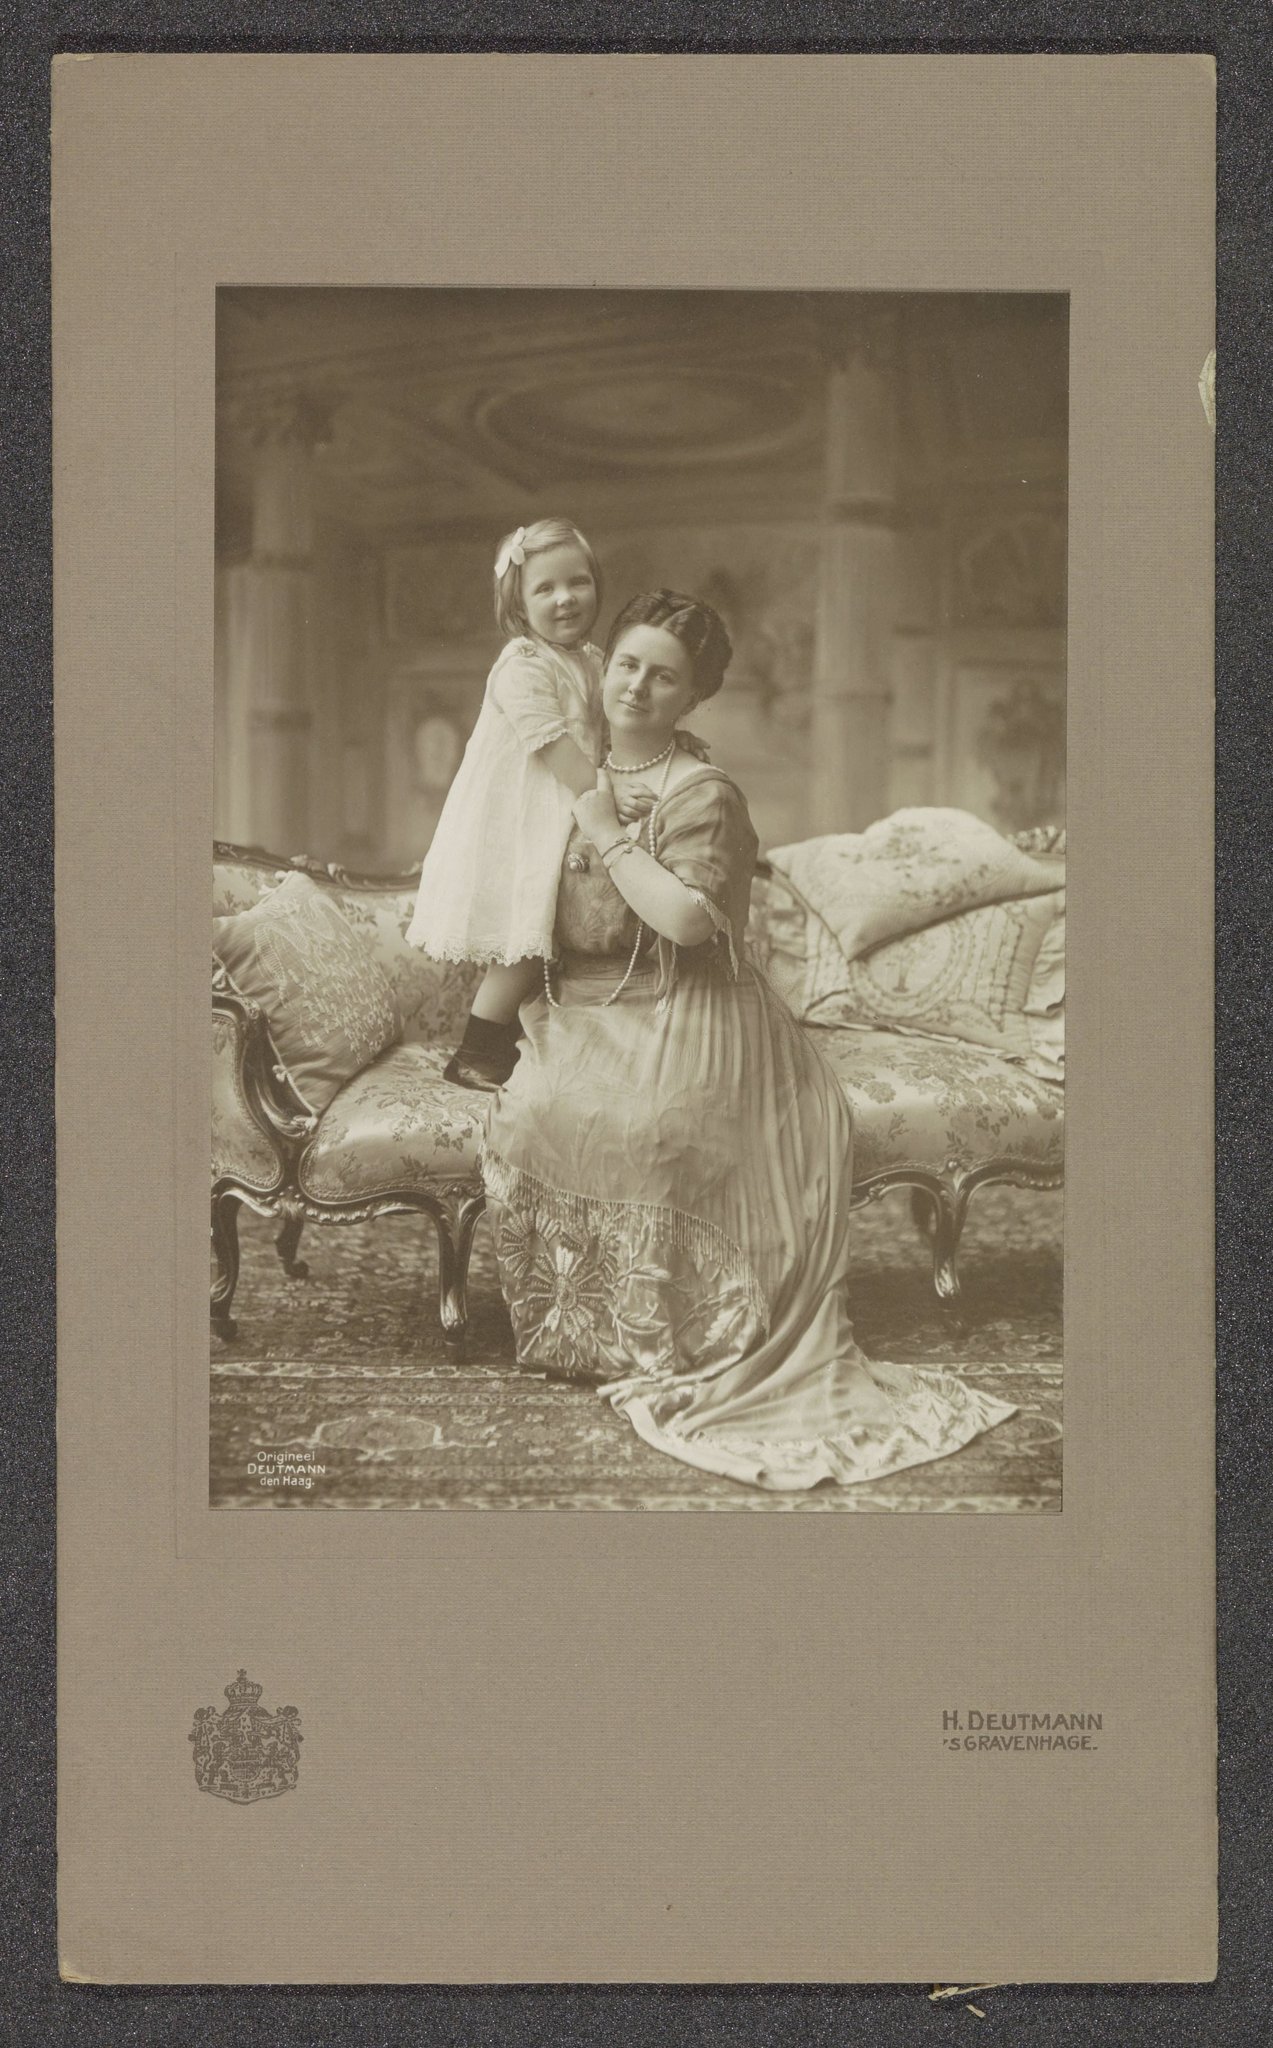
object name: photograph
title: Portret van Koningin Wilhelmina met prinses Juliana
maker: herman deutmann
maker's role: fotograaf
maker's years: 1870-1926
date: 1904-1912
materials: photographic support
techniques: matte daylight collodion silver print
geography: the hague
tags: print maker, wilhelmina of the netherlands, juliana of the netherlands, the hague